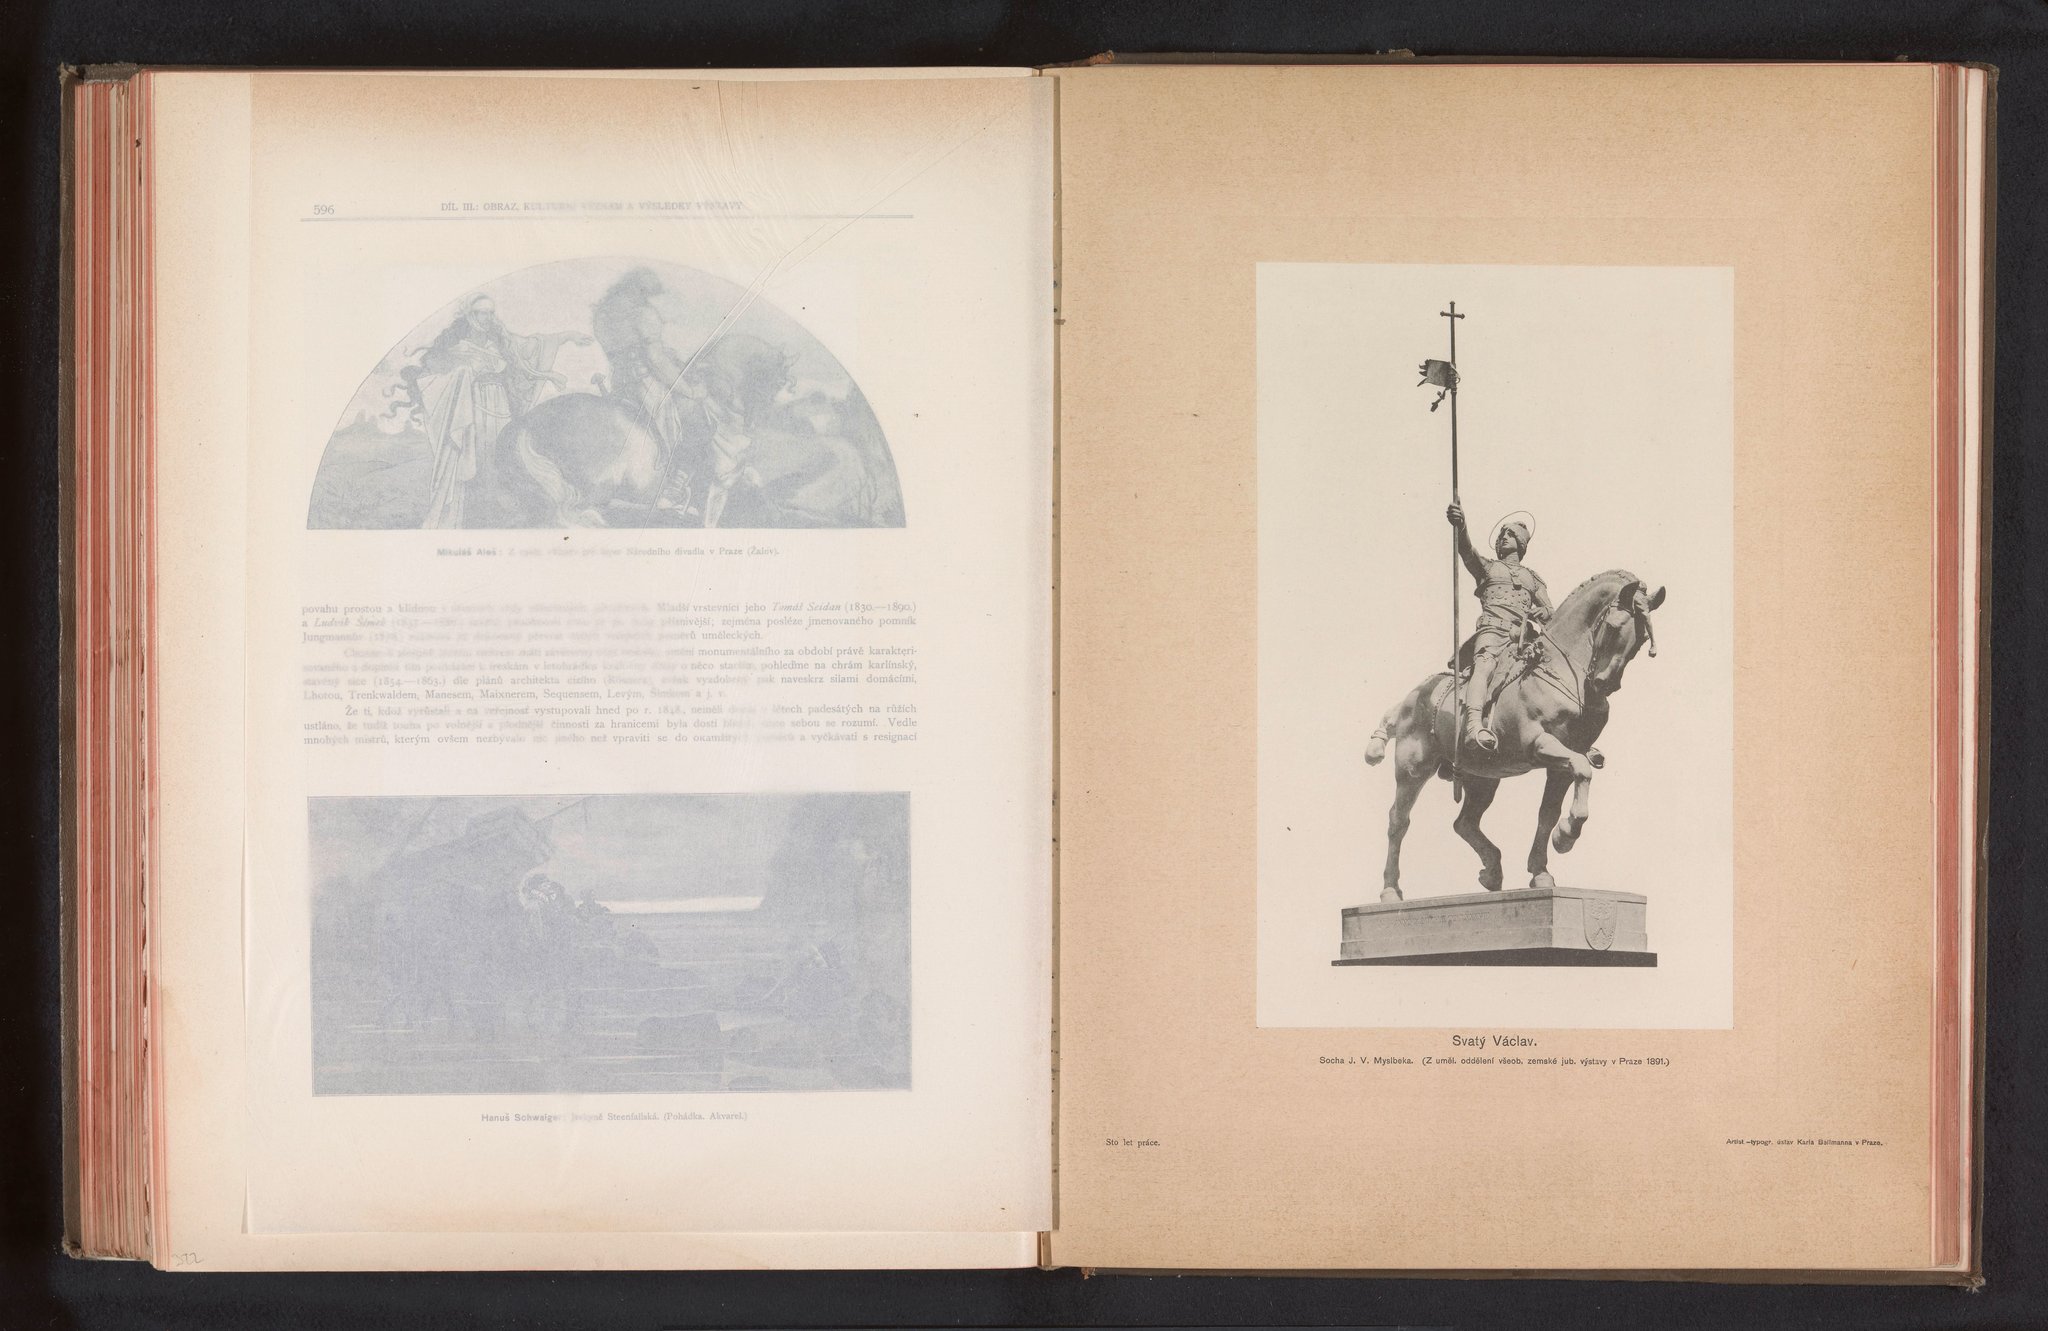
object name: photomechanical print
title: Svatý Václav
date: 1891-1895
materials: paper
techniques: photograph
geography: prague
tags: the martyr and duke of bohemia, wencesla(u)s; possible attributes: bunch of grapes, knight's armour, ducal hat, lance, shield, sword, wine press, equestrian statue